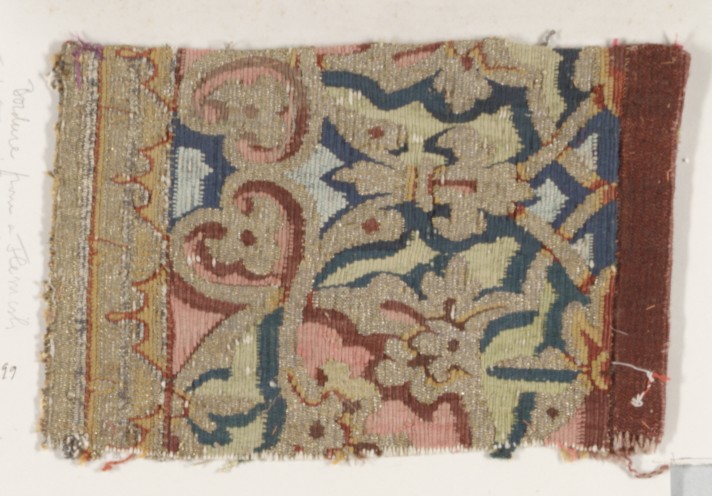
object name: tapestry fragment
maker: willem de pannemaker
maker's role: workshop director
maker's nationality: flemish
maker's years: 1535-1581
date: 1550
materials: metal thread, silk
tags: flowers